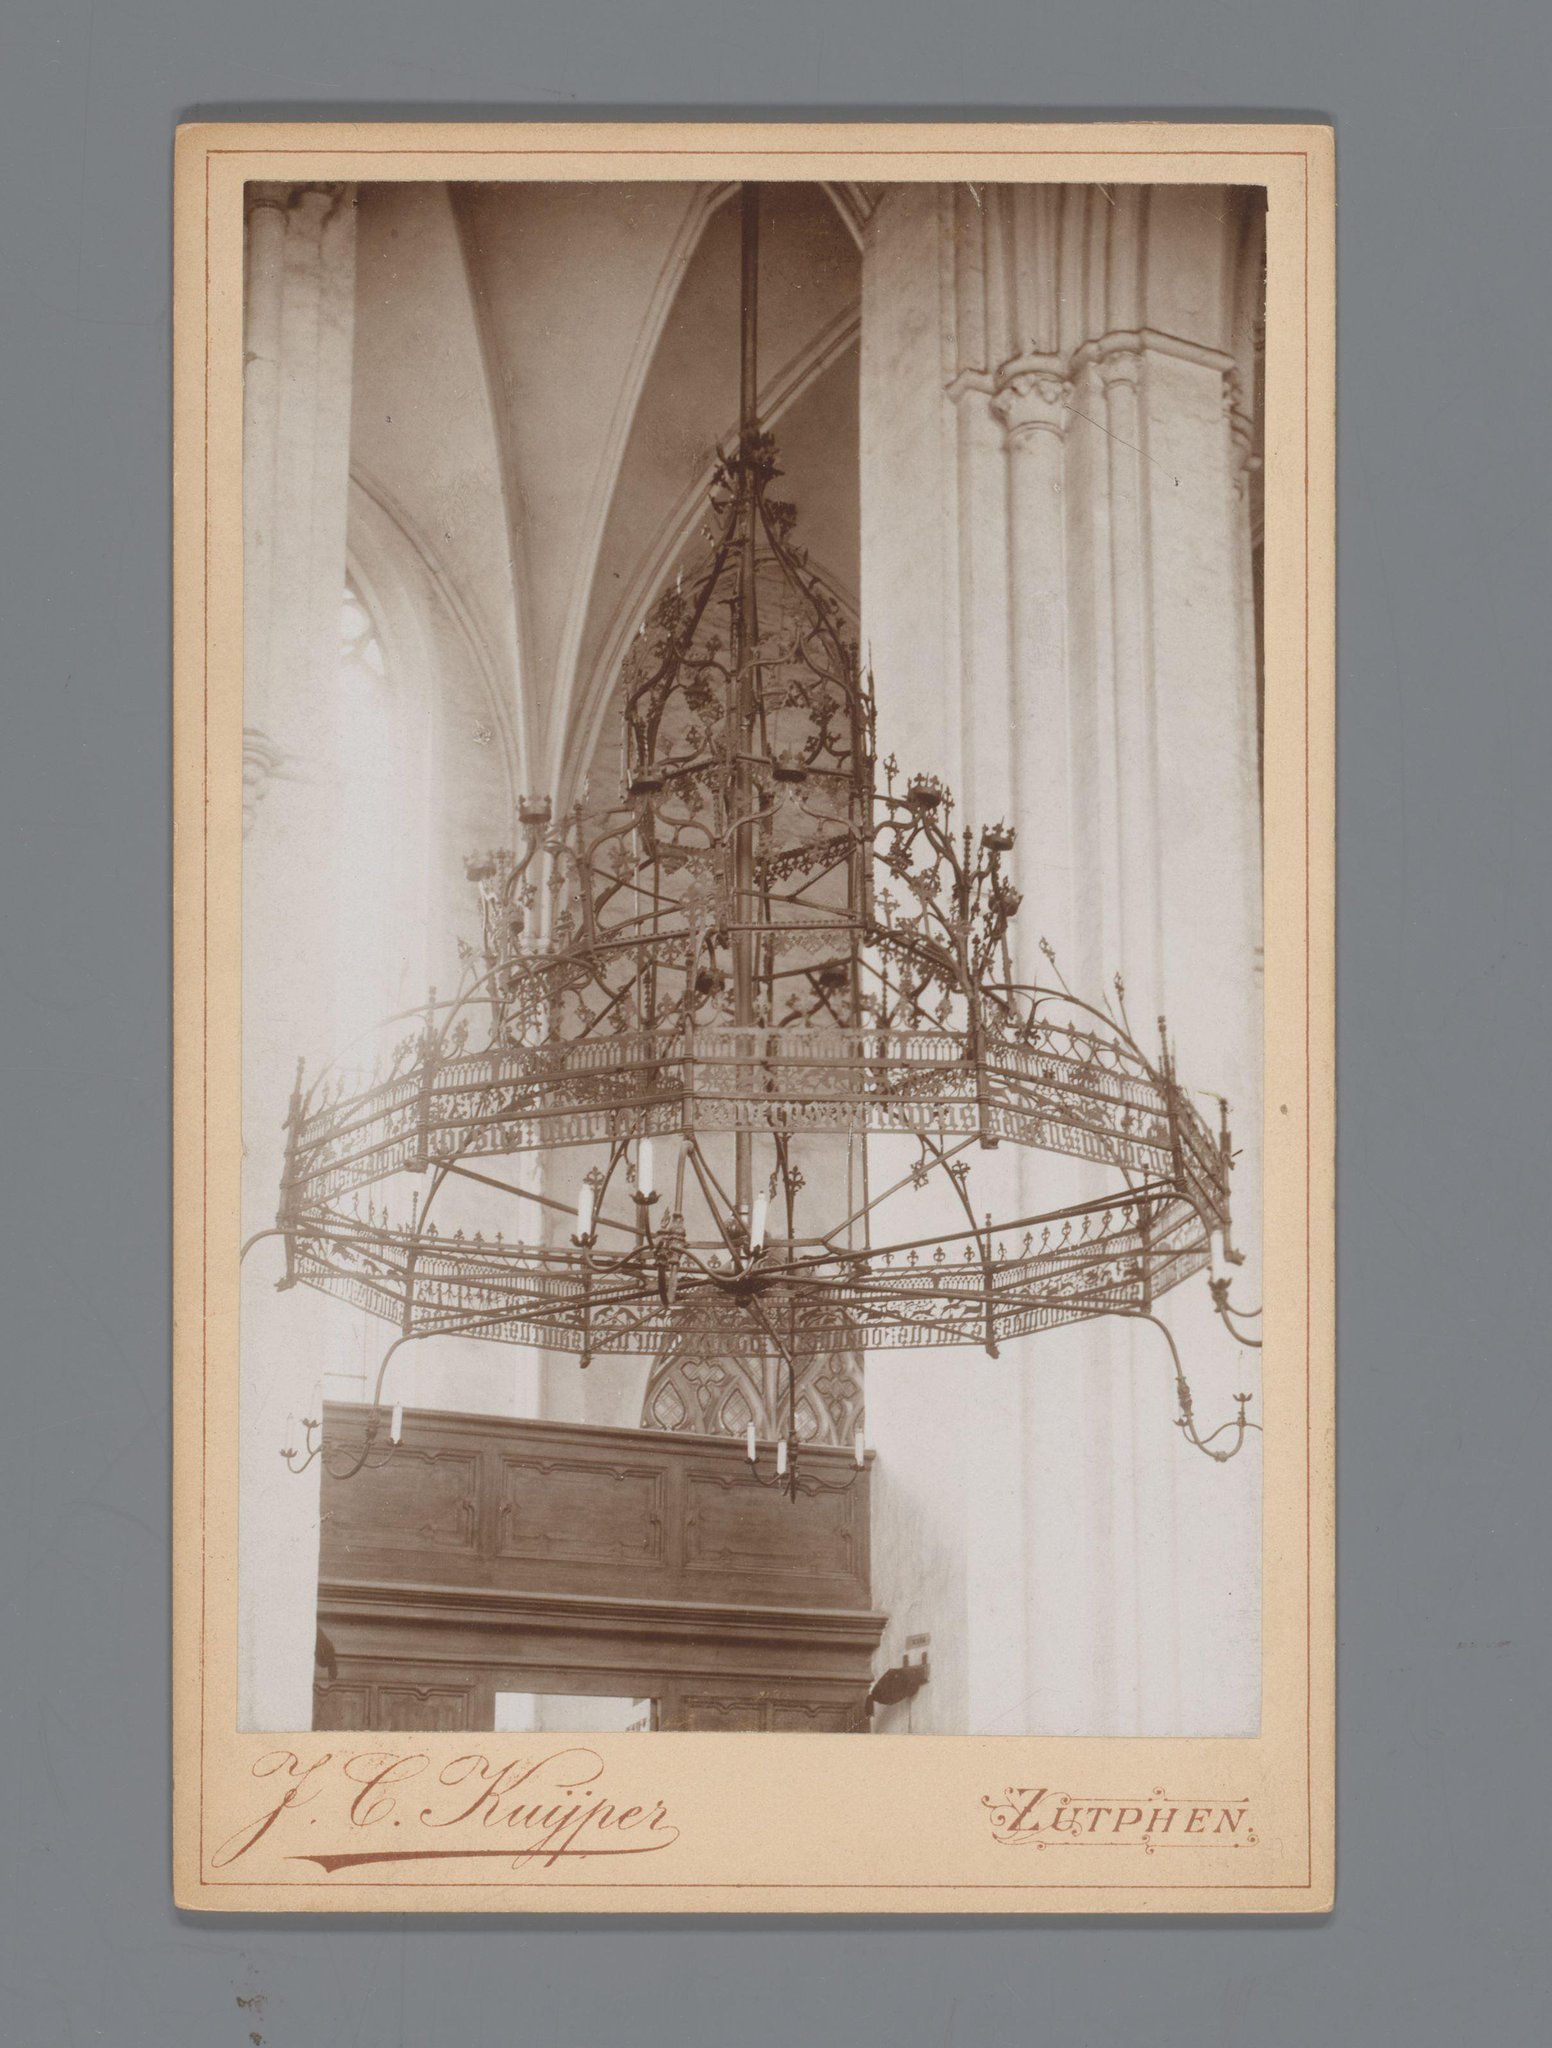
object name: cabinet photograph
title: Kroonluchter in de Walburgiskerk te Zutphen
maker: jacobus cornelis kuijper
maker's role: fotograaf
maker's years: 1852-1924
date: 1880-1915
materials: cardboard, photographic support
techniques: collodion silver print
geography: zutphen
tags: chandelier, candelabrum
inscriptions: inscription: ‘Photografie Instantanée/ J.C. Kuijper/ Zutphen/ Boompjeswal en Bornhovestraat E.141’